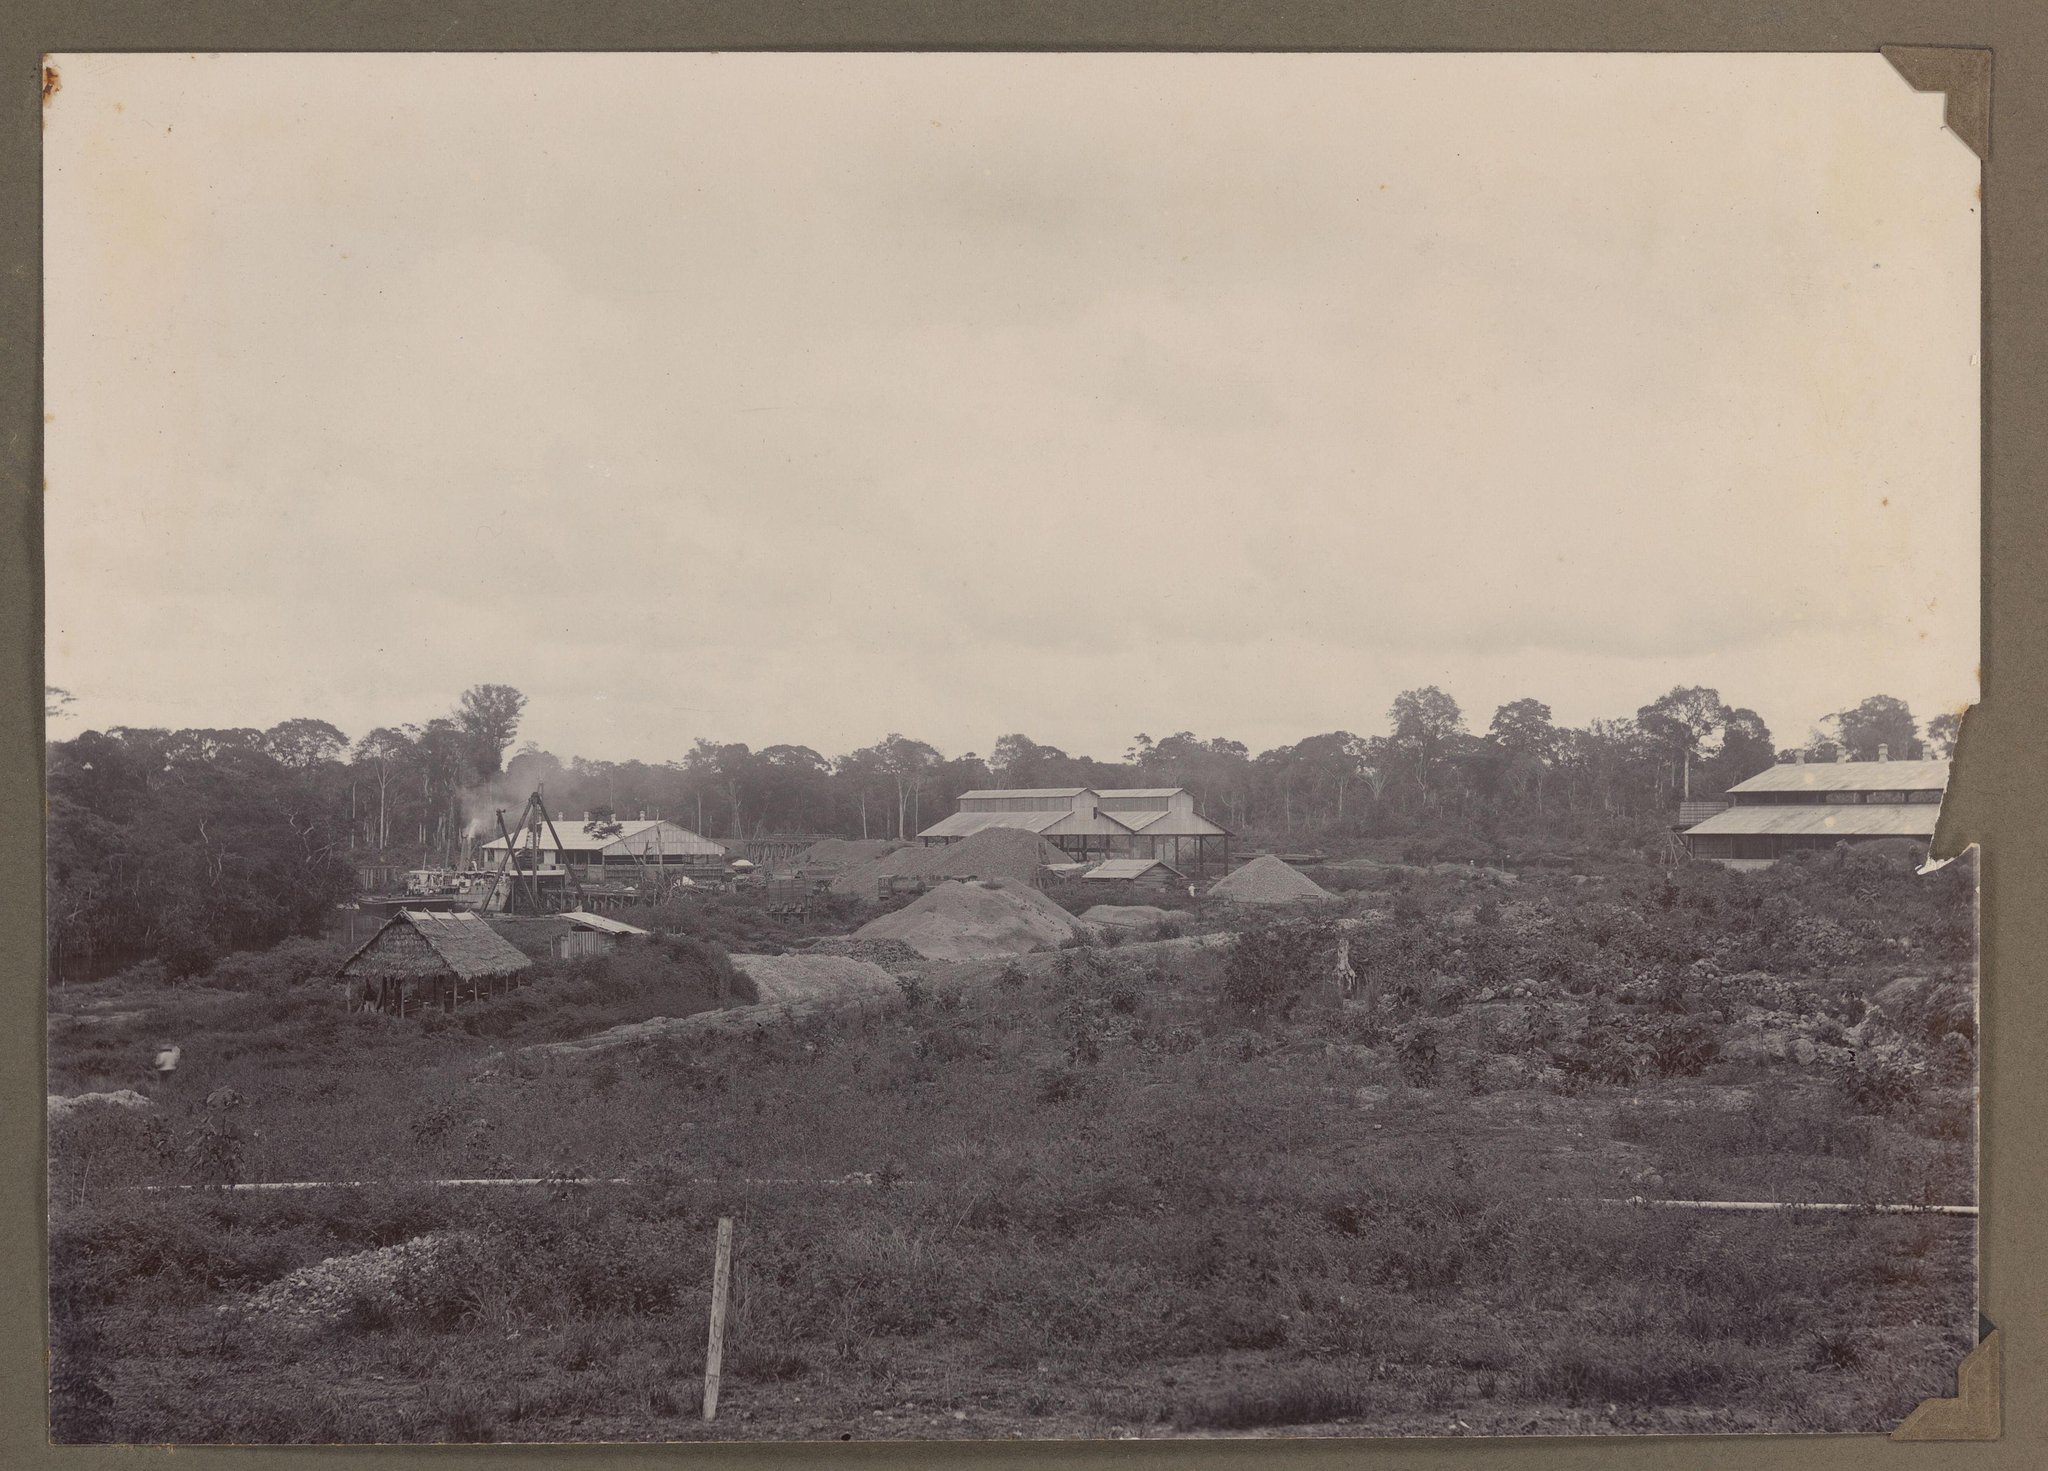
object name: photograph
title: Terrein van mijn en fabriek te Moengo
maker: Anonymous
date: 1925-1927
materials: photographic support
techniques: photography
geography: suriname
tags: jetten, familie, moengo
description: Terrein van de mijn en fabriek te Moengo. Foto op een bladzijde van een los albumblad. Onderdeel van het ensemble met foto's van de familie van ingenieur Jetten in de mijnbouwstad Moengo in Suriname.